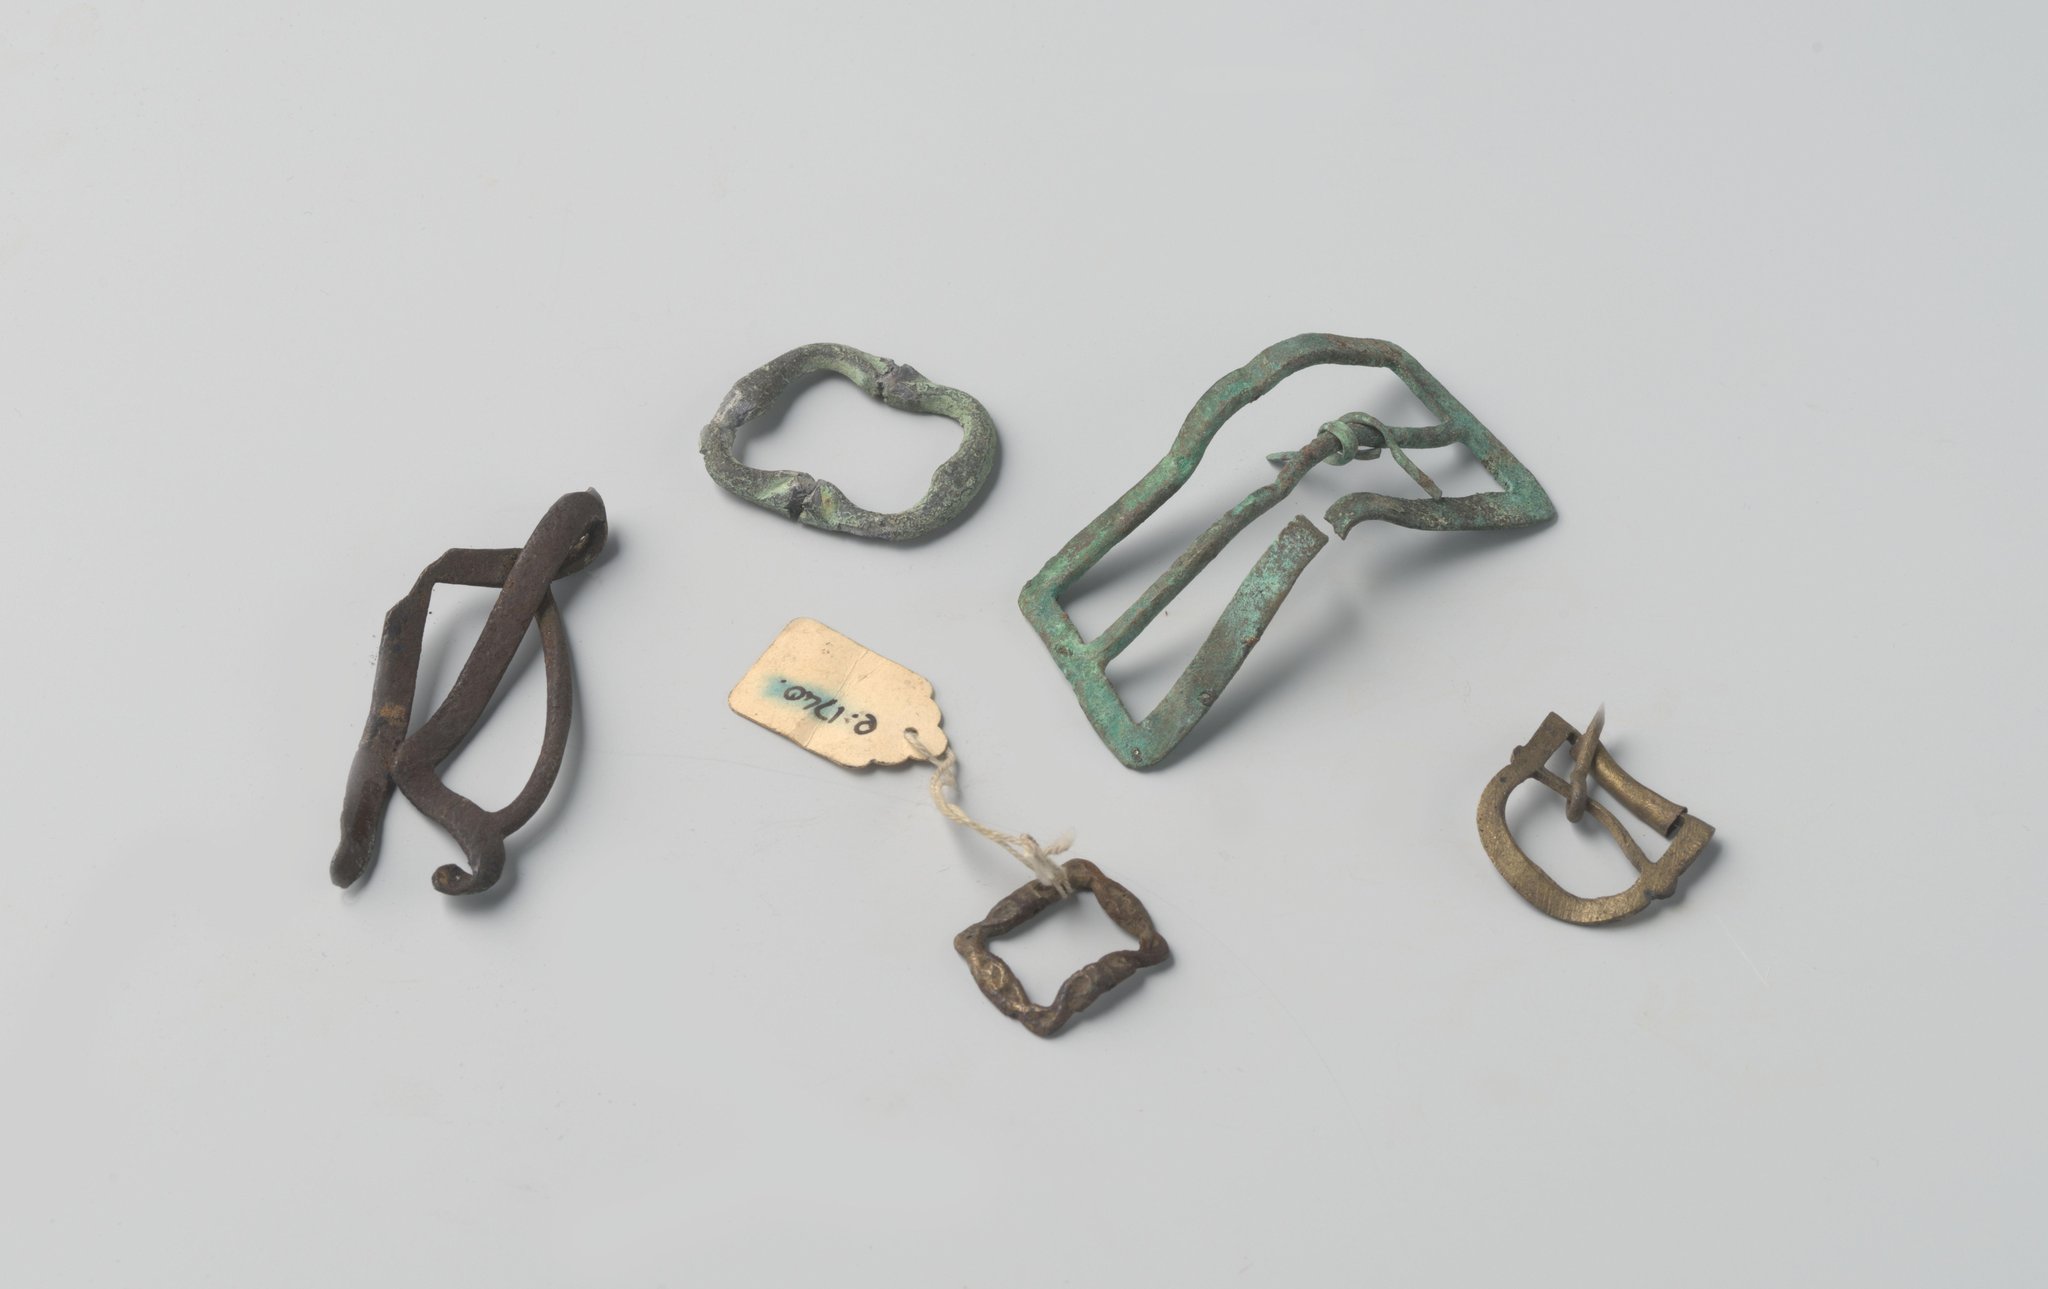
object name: buckle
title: Gespen uit het wrak van de Oostindiëvaarder Hollandia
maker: Anonymous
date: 1700-1743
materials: bronze, copper, tin